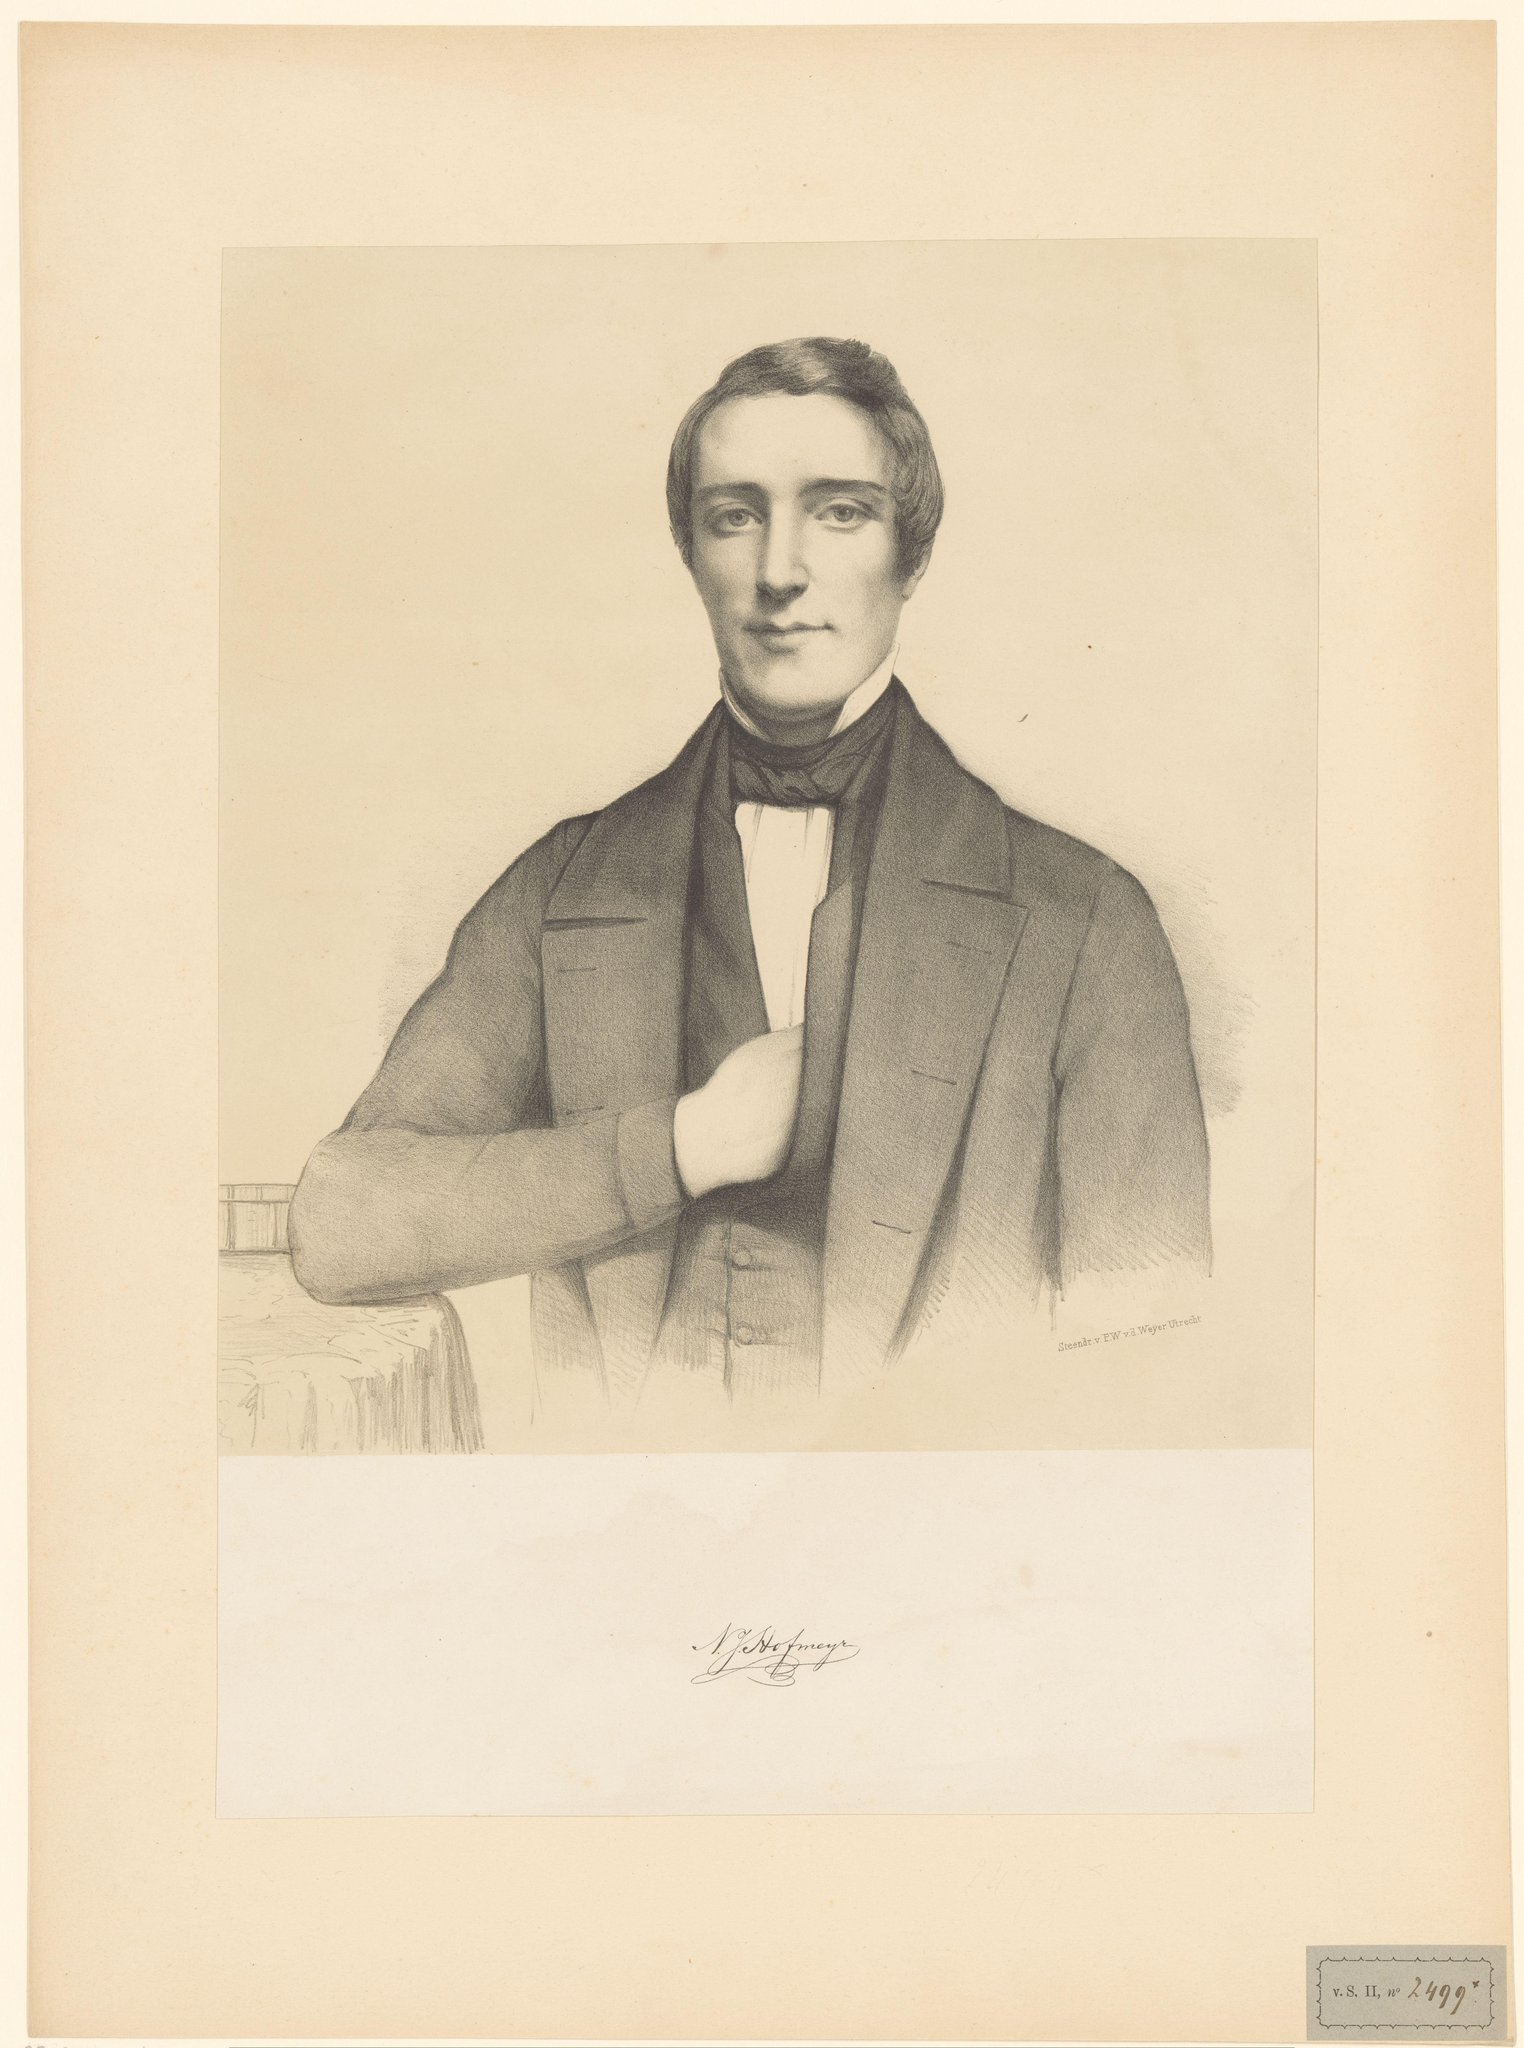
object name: print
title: Portret van N.J. Hofmeyr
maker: pieter wilhelmus van de weijer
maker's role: print maker, printer, publisher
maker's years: 1816-1880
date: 1842-1880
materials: paper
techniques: tone lithography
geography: utrecht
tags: historical persons (+ (full) bust portrait)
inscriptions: collector's mark: Lugt 2228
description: Onder het portret de signatuur van de geportretteerde.